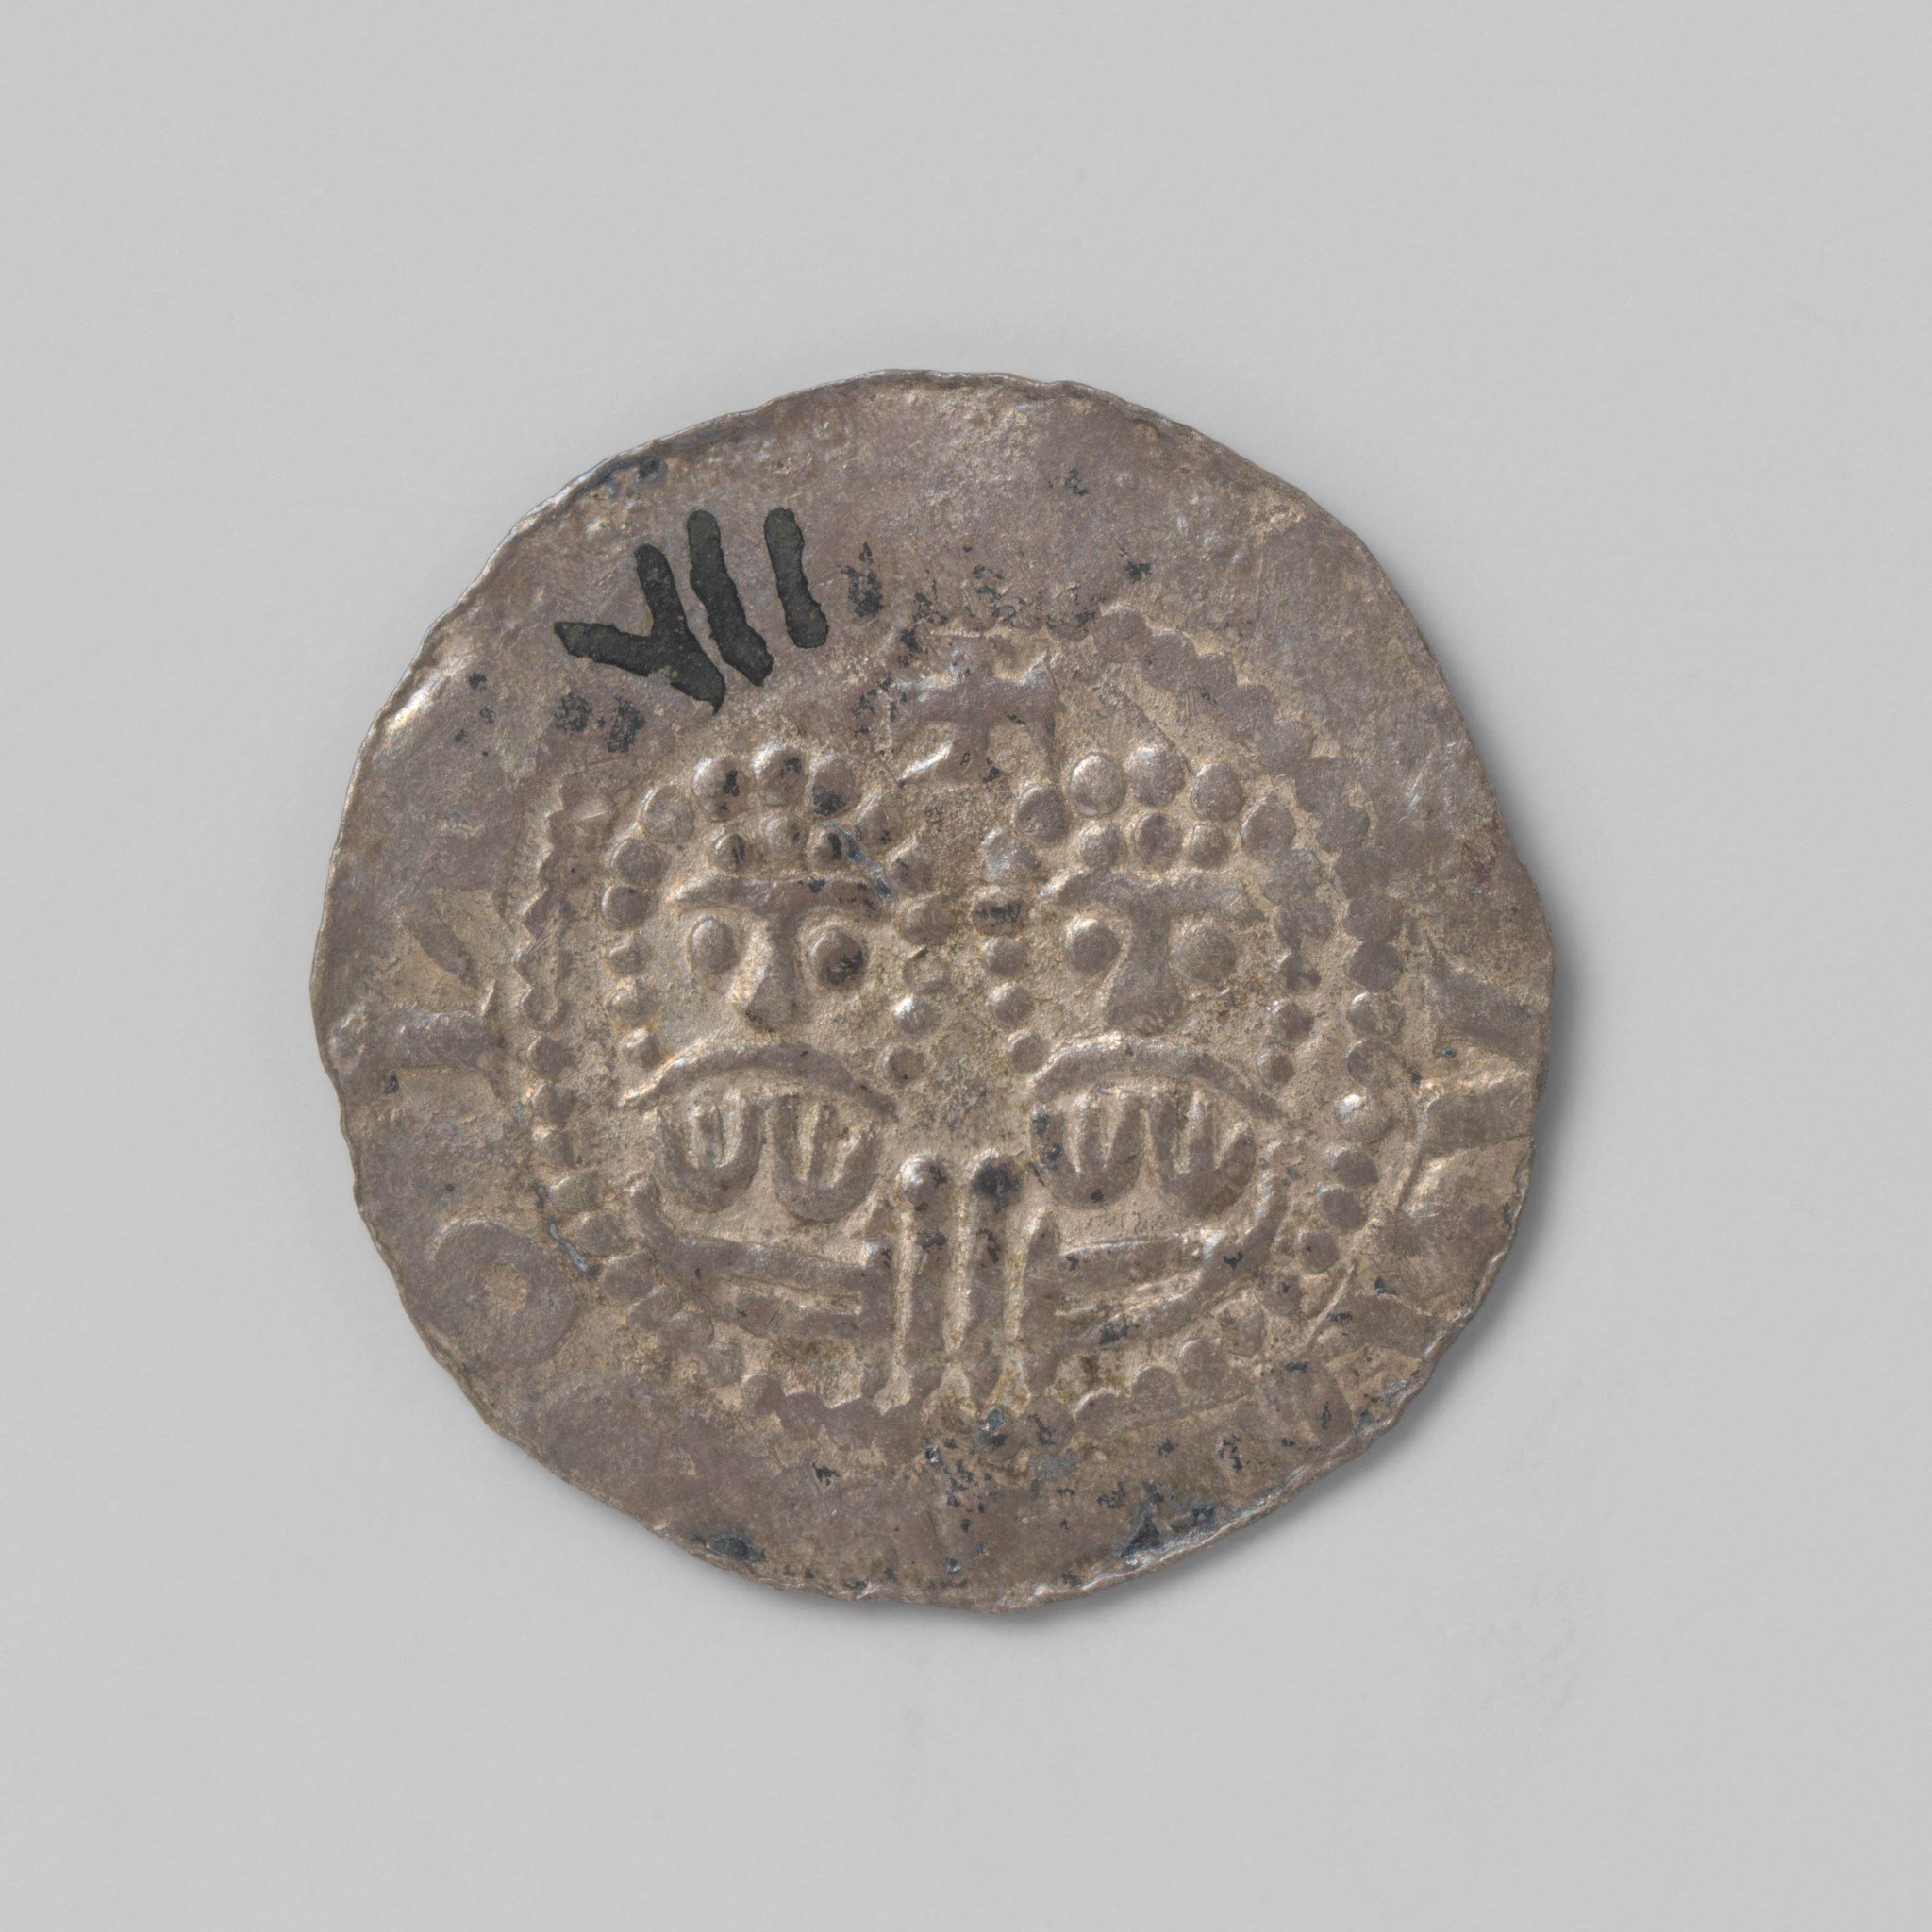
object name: penny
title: Friese penning van graaf Egbert II, 1068-1090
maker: egbert ii van meissen (graaf van friesland)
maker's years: 1060-1090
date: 1068-1090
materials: silver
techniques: striking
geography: stavoren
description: Zilveren munt. Voorzijde: aanziende vorst. Daaromheen omschrift. Keerzijde: aanziende Simon en Judas. Daaromheen omschrift /TAVE/ON